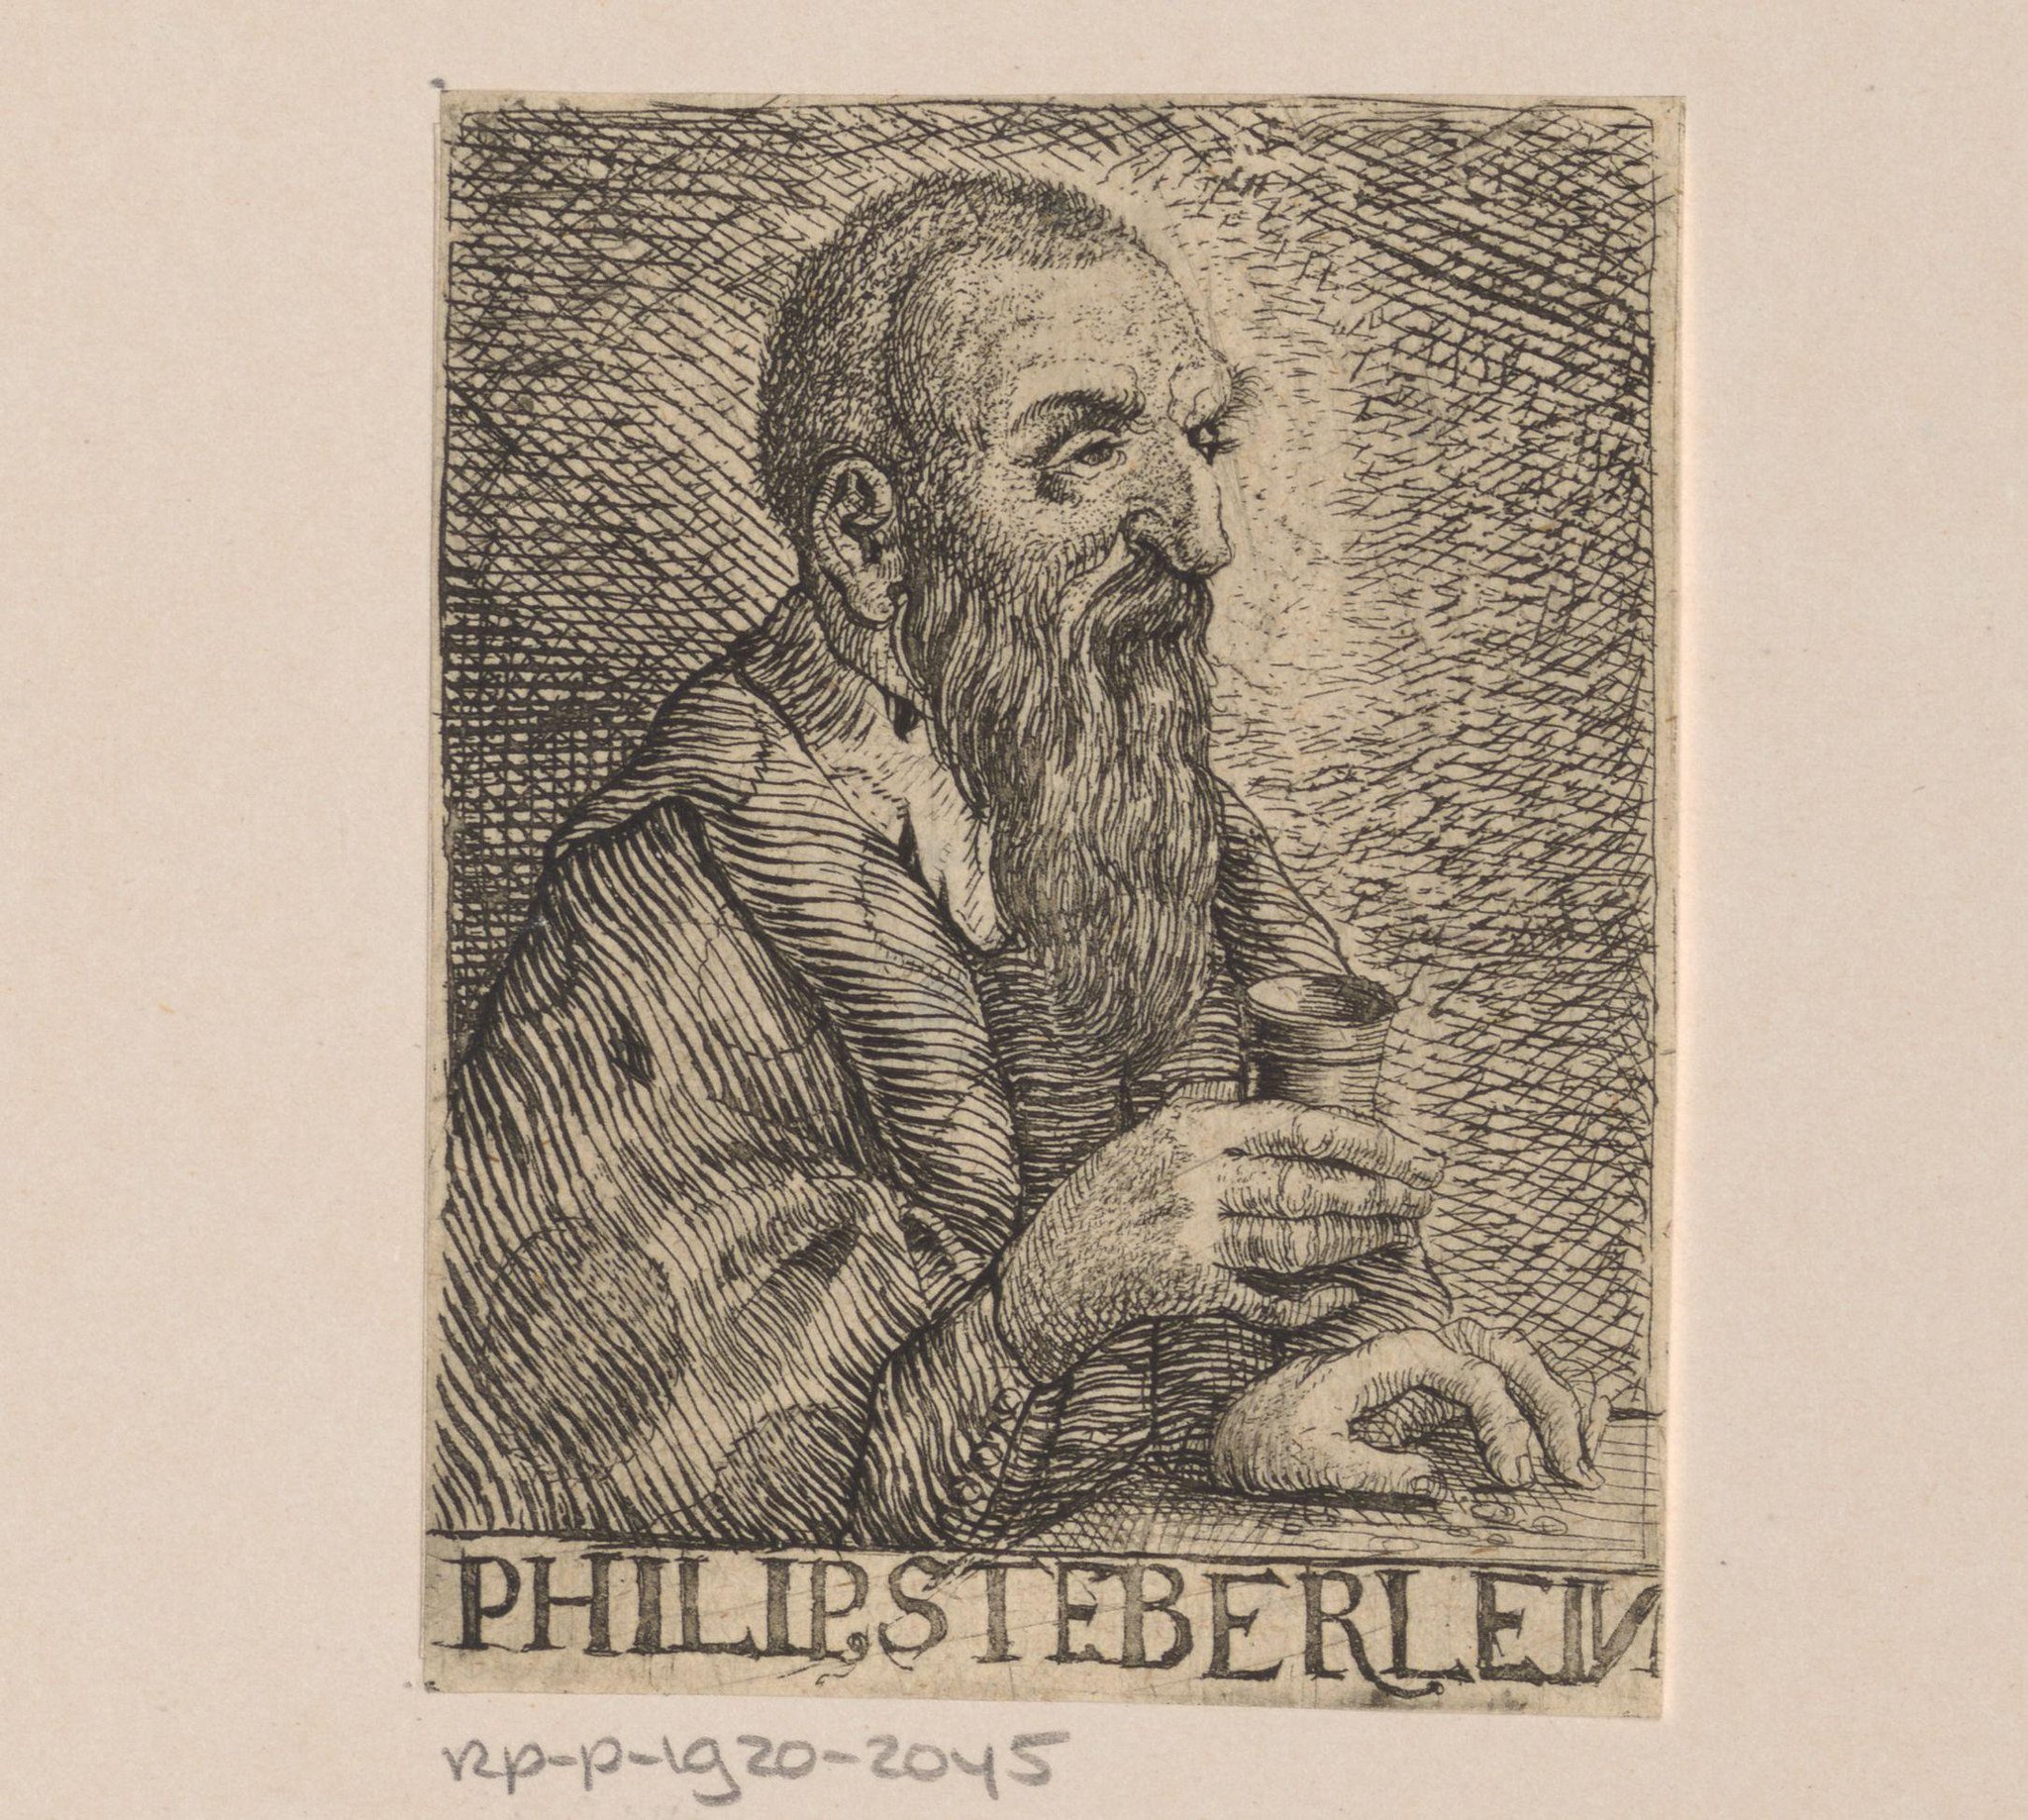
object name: print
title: Portret van Philipp Stöberlein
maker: Anonymous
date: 1600-1699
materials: paper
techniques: etching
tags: pharmacist, druggist, apothecary; pharmacy, drugstore, dispensing chemist, historical persons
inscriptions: collector's mark: Lugt 2228